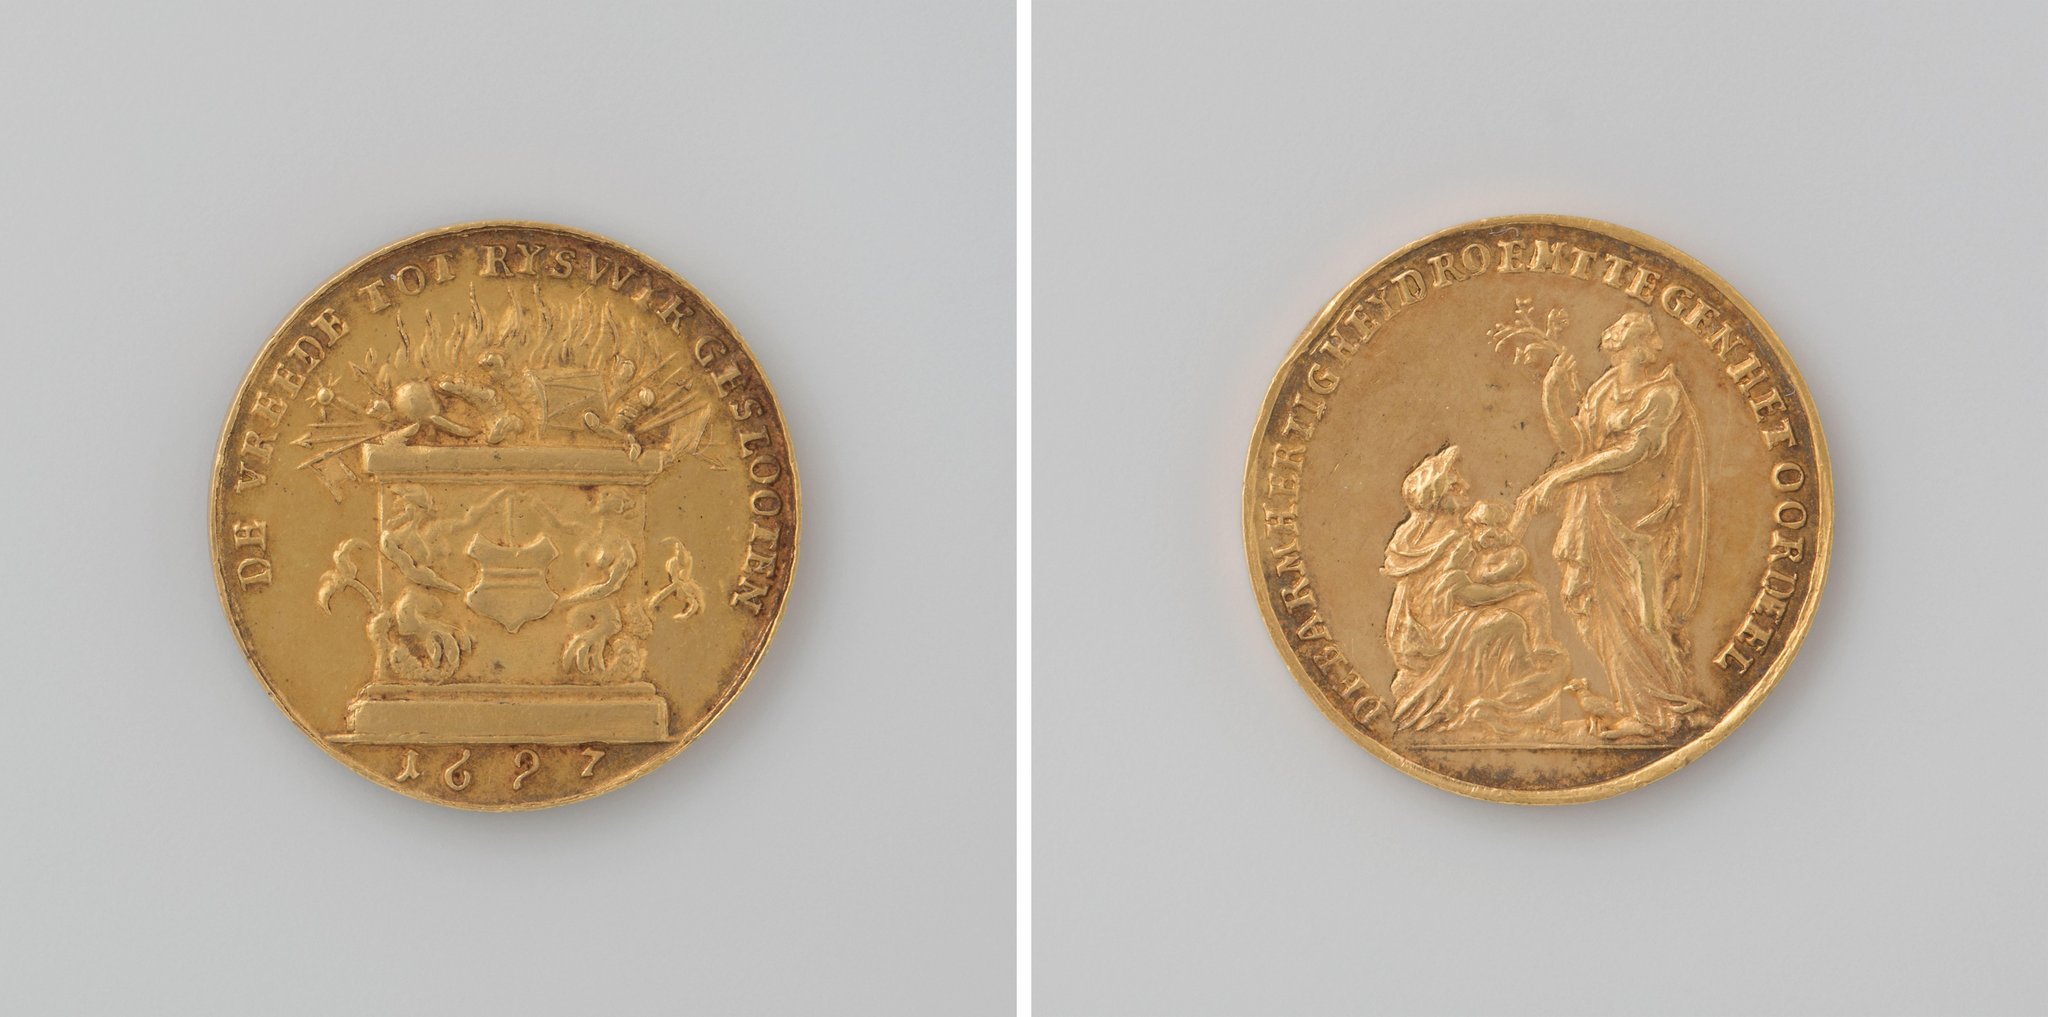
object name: medal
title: Vrede van Rijswijk, penning uitgedeeld aan ieder die in de loterij van Muiden geen prijs heeft gewonnen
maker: jan luder (i)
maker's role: medailleur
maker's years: 1648-1719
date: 1697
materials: gold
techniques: striking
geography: netherlands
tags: muiden, rijswijk, vrede van rijswijk (1697)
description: Gouden penning. Voorzijde: Barmhartigheid met vredestak beurt bedrukte moeder met kind in de armen op, in het midden een vogeltje binnen omschrift. Keerzijde: oorlogstuig brandend op een altaar, waarvoor twee meermannen wapenschild houden binnen omschrift; afsnede: jaartal